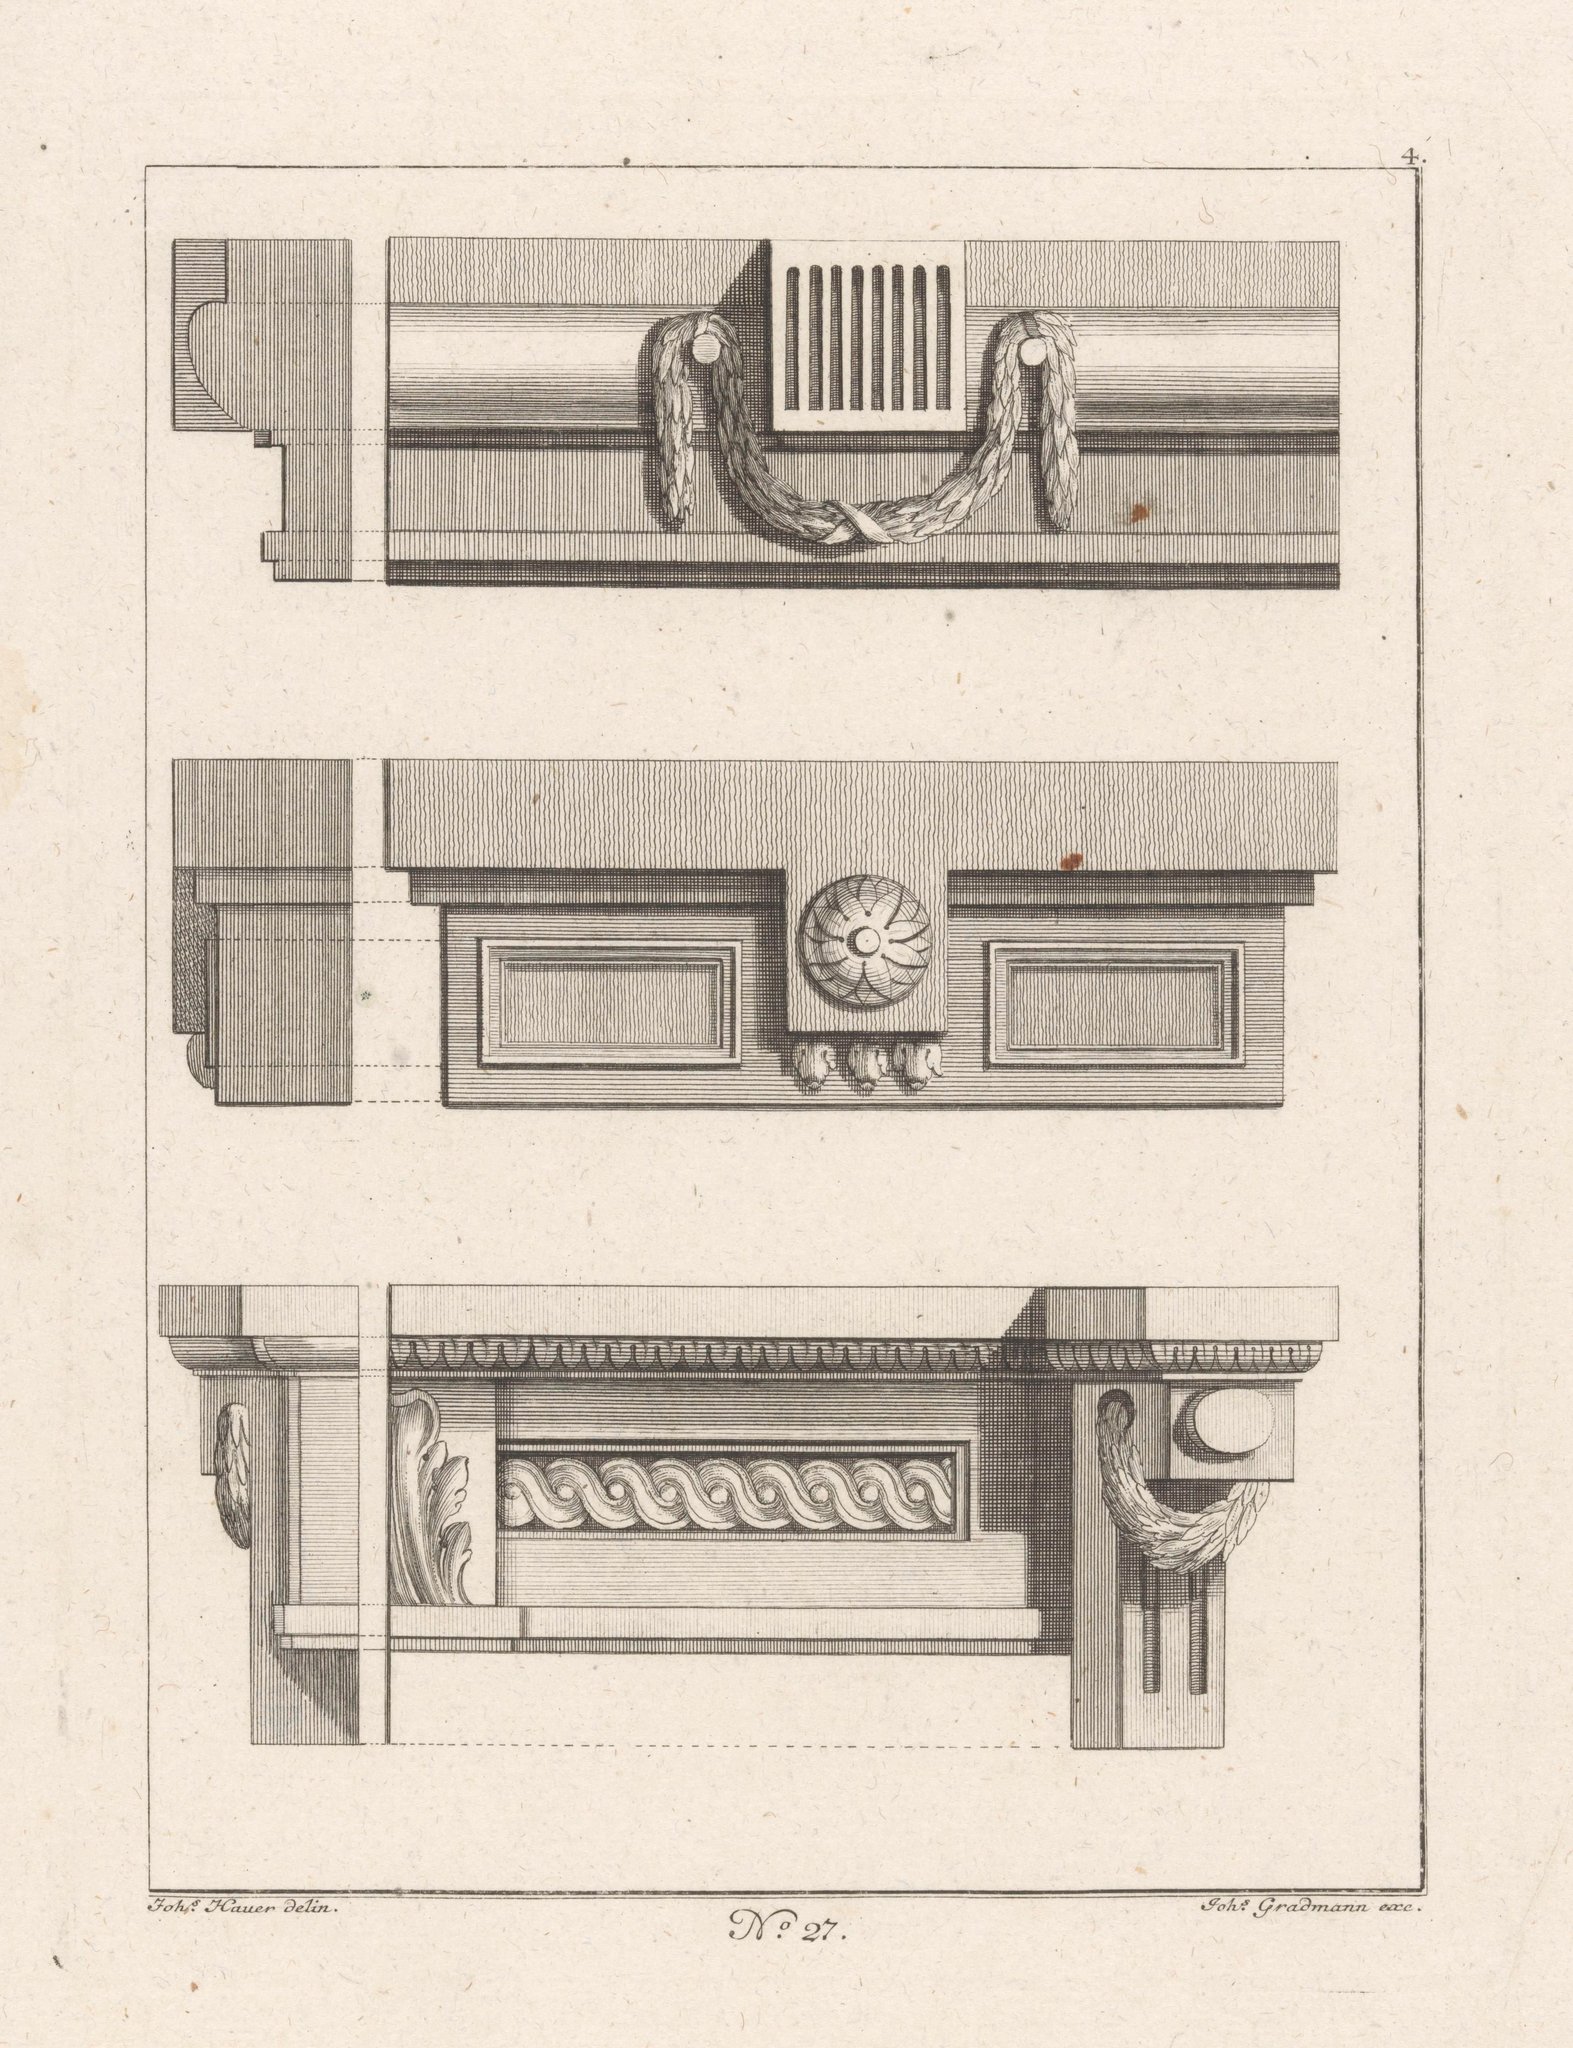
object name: ornament print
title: Drie lijsten en zijaanzichten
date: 1758-1820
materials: paper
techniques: engraving, etching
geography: ravensburg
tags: ornaments ~ art (+ framing decorations)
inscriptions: collector's mark: Lugt 2760, collector's mark: Lugt 2228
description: Ontwerpen en zijaanzichten van drie lijsten met ornamenten, bladmotieven en guirlandes. Uitgeversnummer 27.